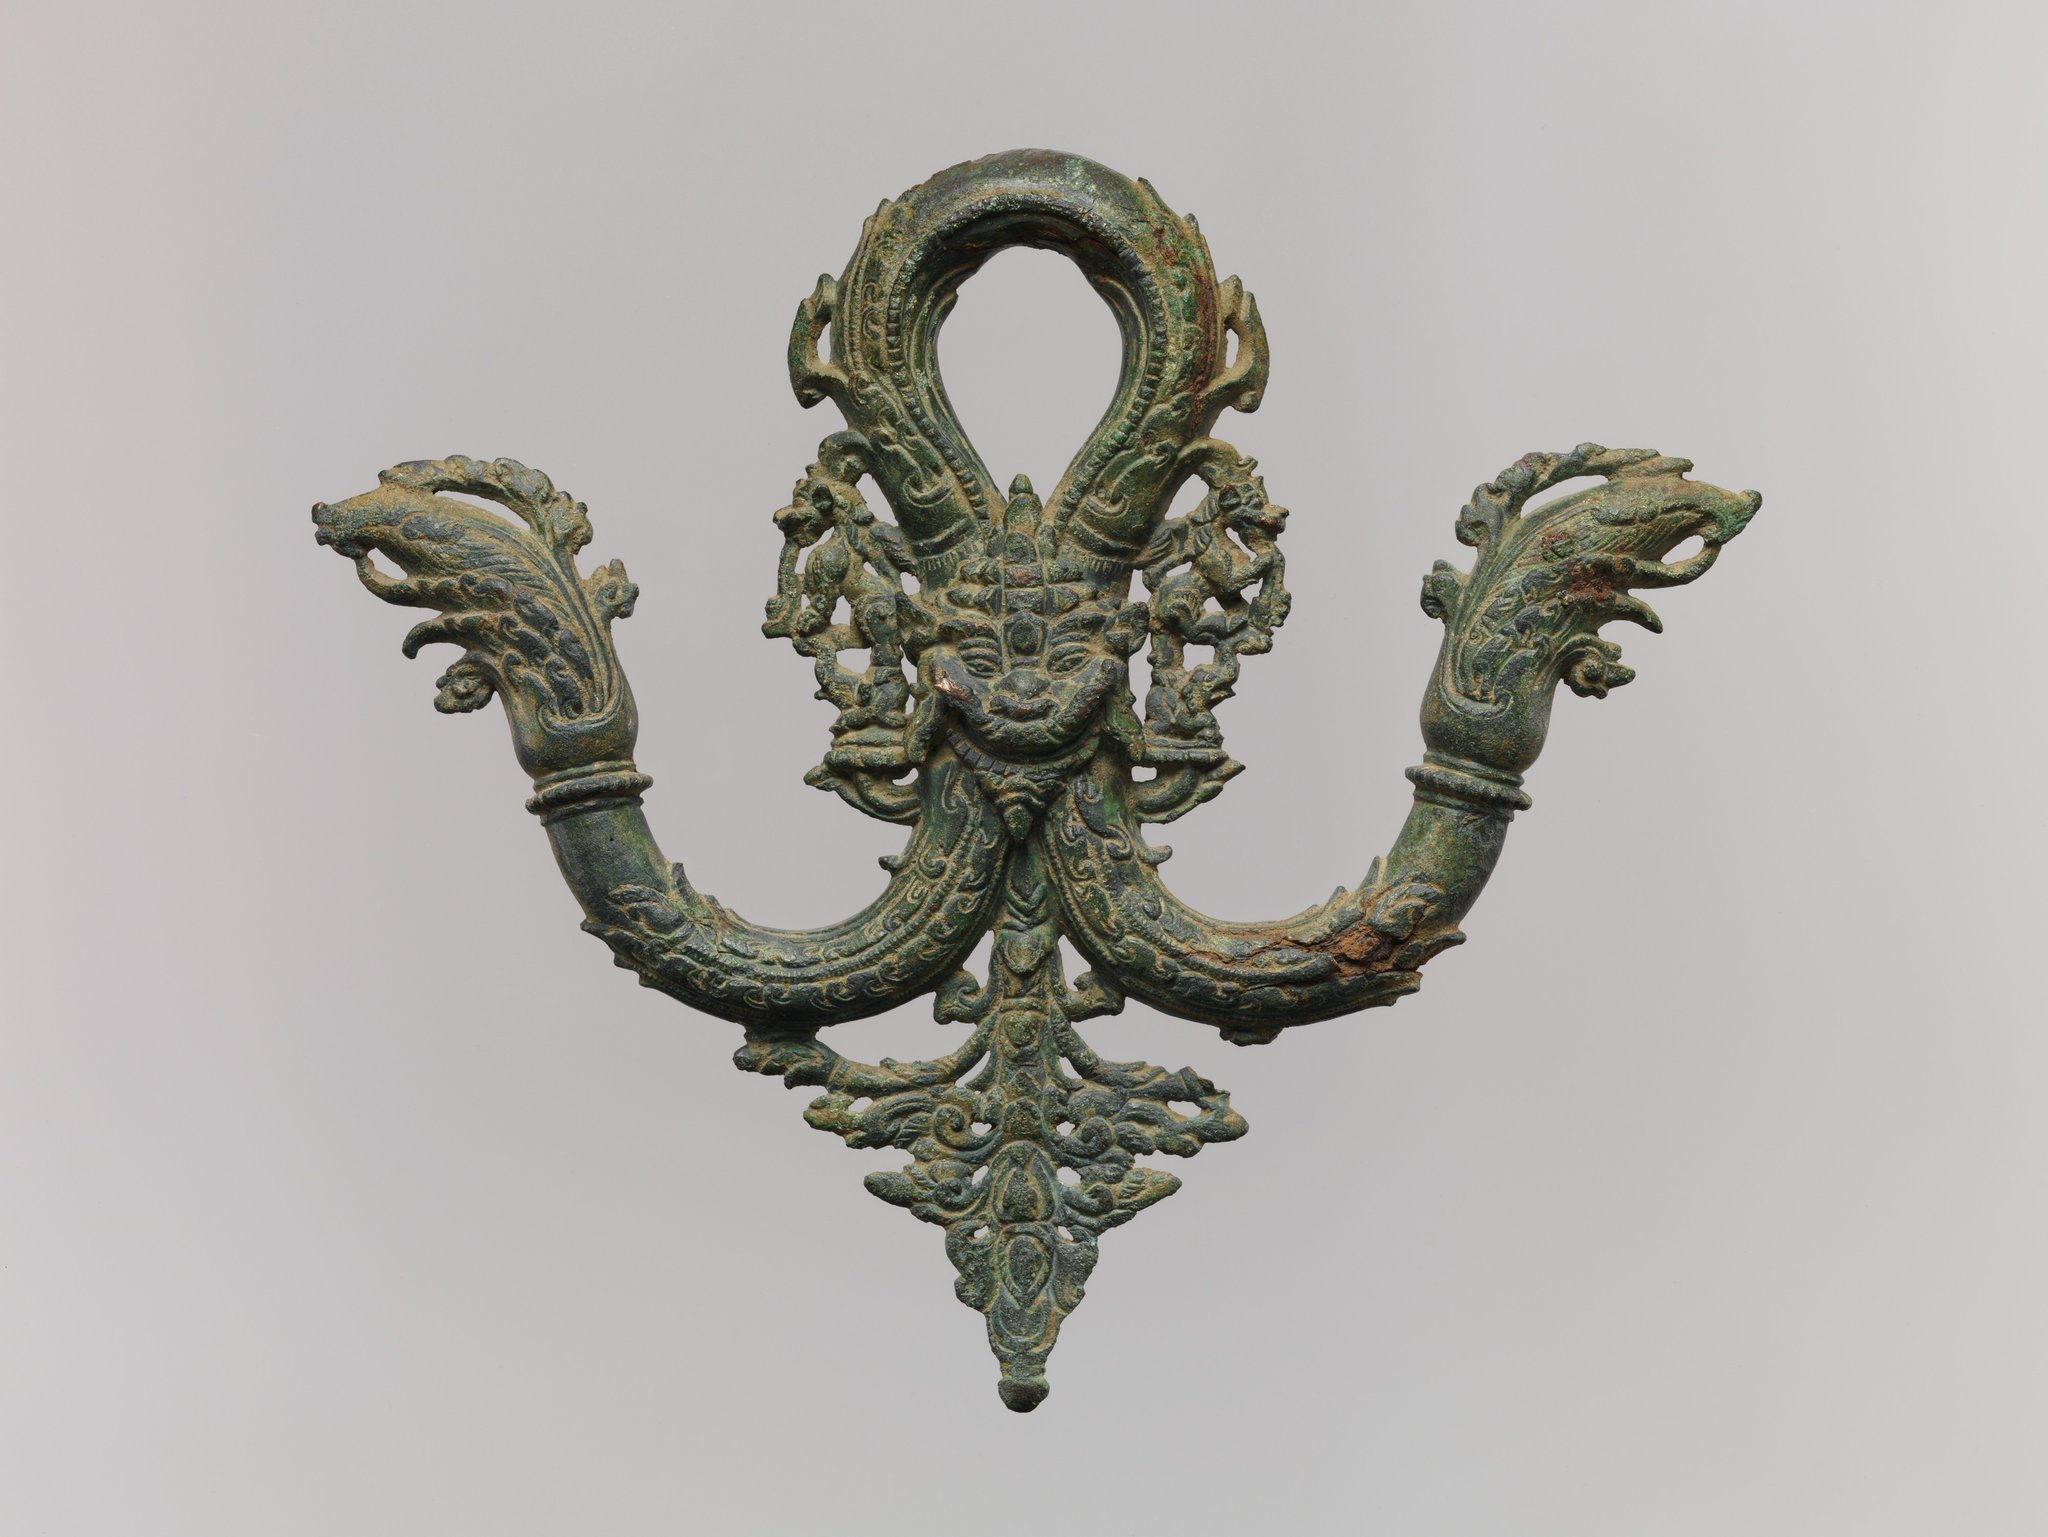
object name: architect's plummet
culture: sri lankan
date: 1101-1200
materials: copper alloy, iron